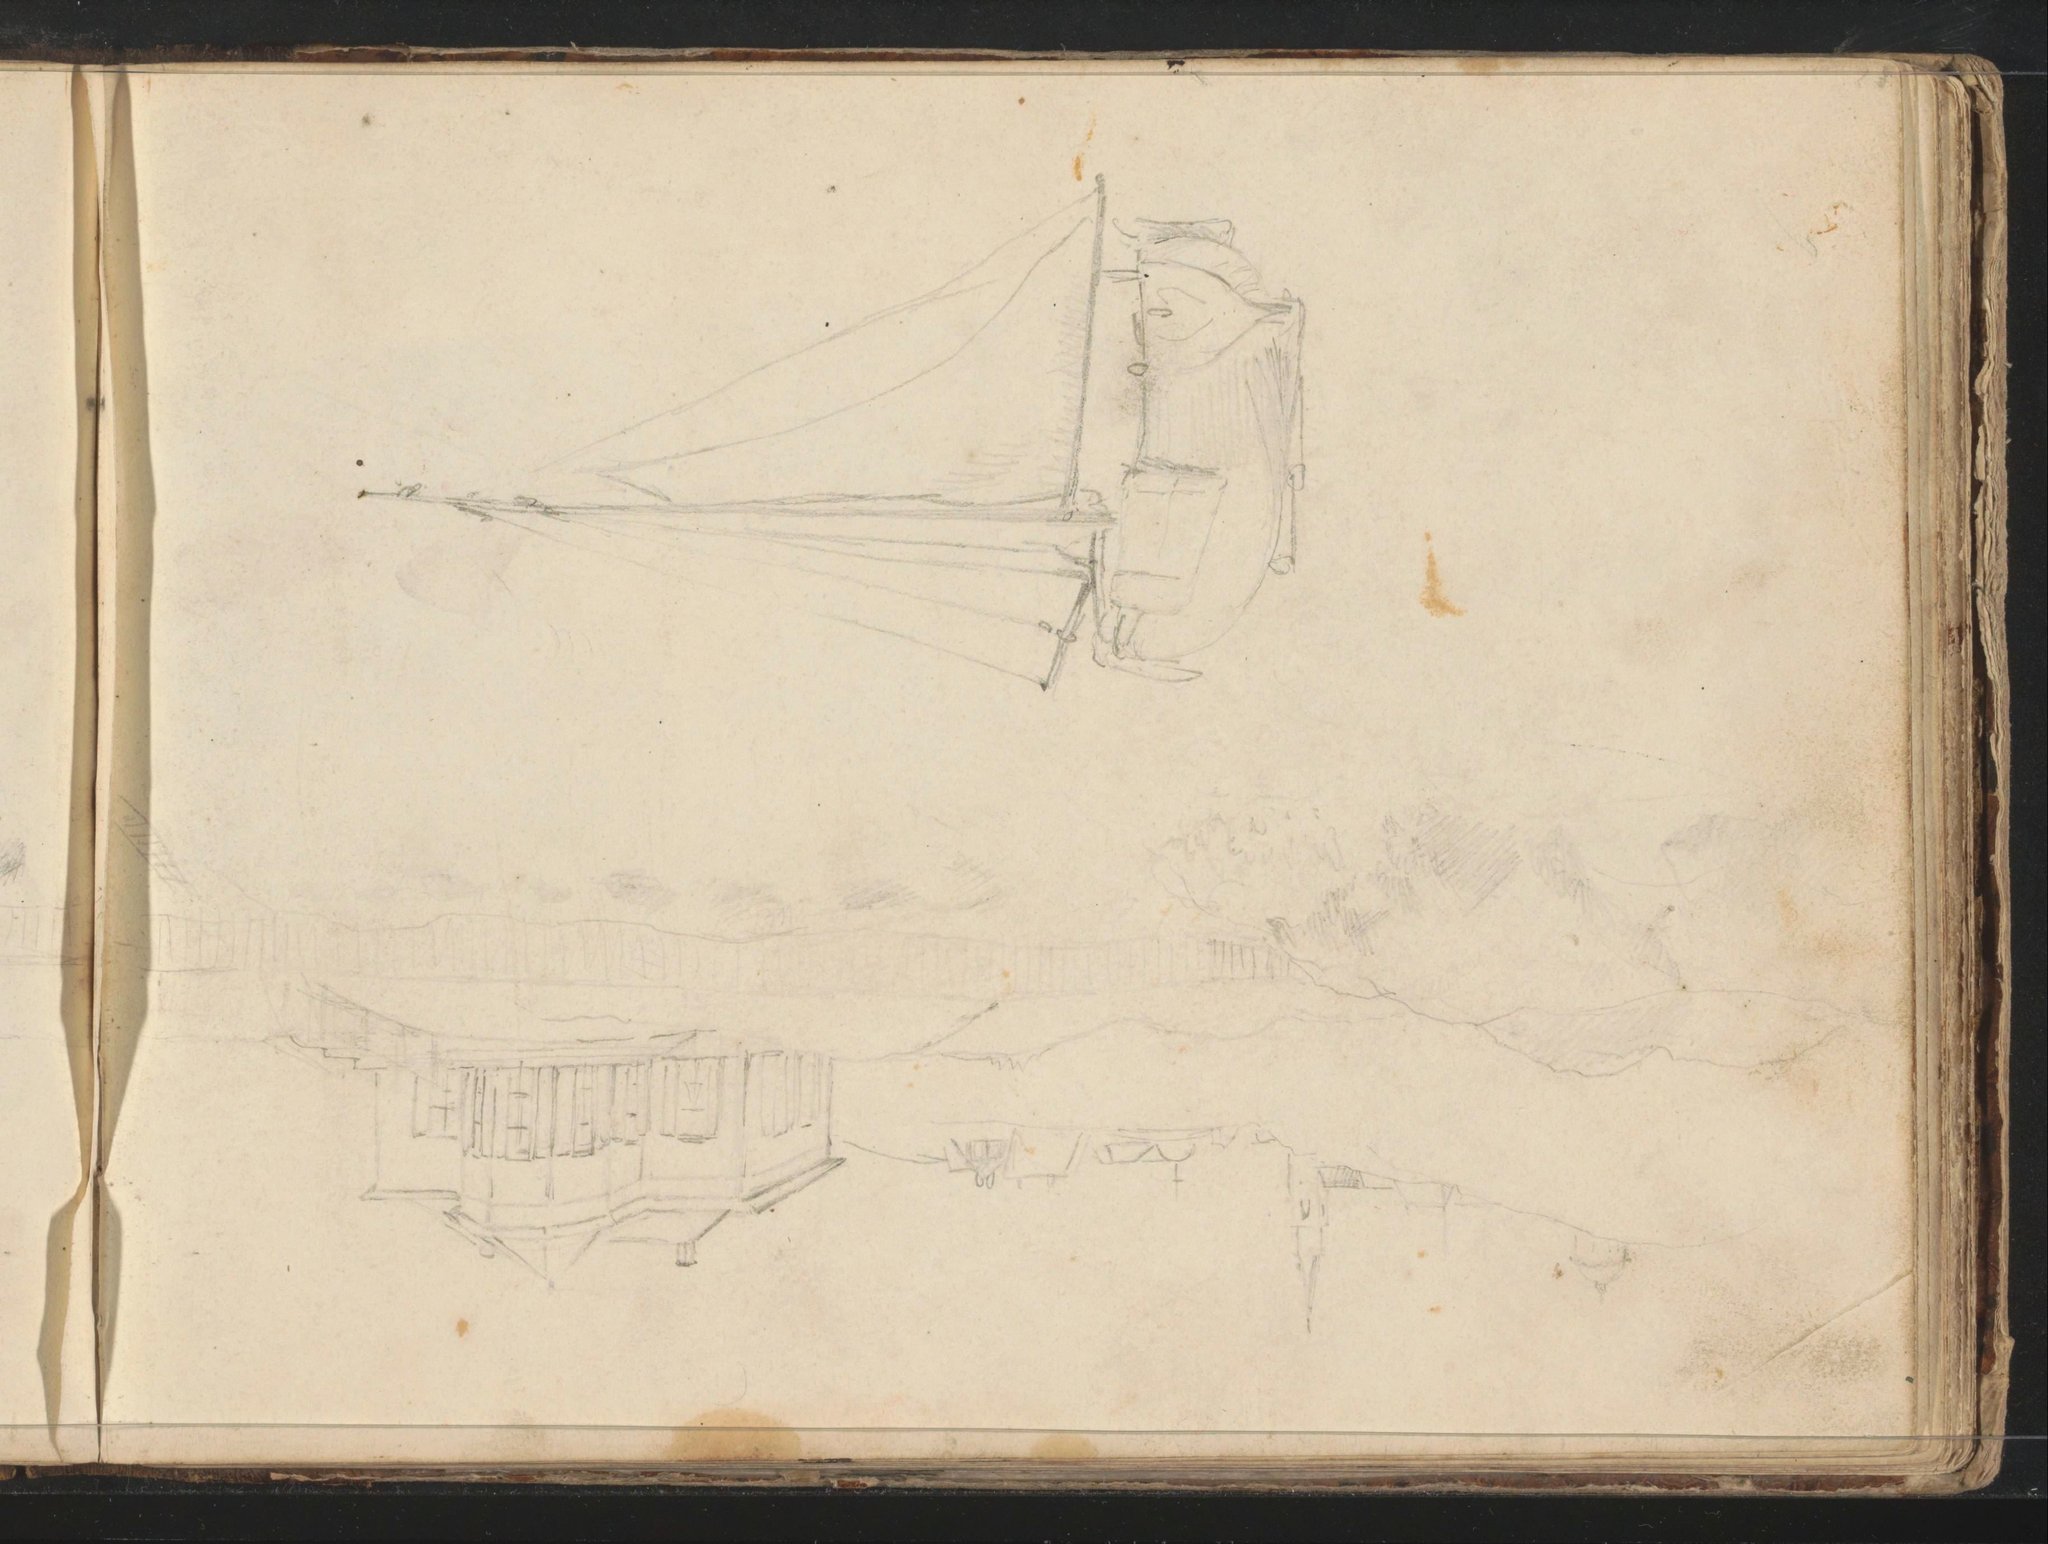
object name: sketchbook leaf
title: Gezicht op Scheveningen en een zeilboot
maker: willem troost (ii)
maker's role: draughtsman, painter, print maker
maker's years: 1812-1893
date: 1822-1893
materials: paper, pencil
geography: scheveningen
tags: city-view, and landscape with man-made constructions, sailing-ship, sailing-boat, dunes (sea not visible); in the dunes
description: Blad 28 recto uit een schetsboek met 36 bladen.